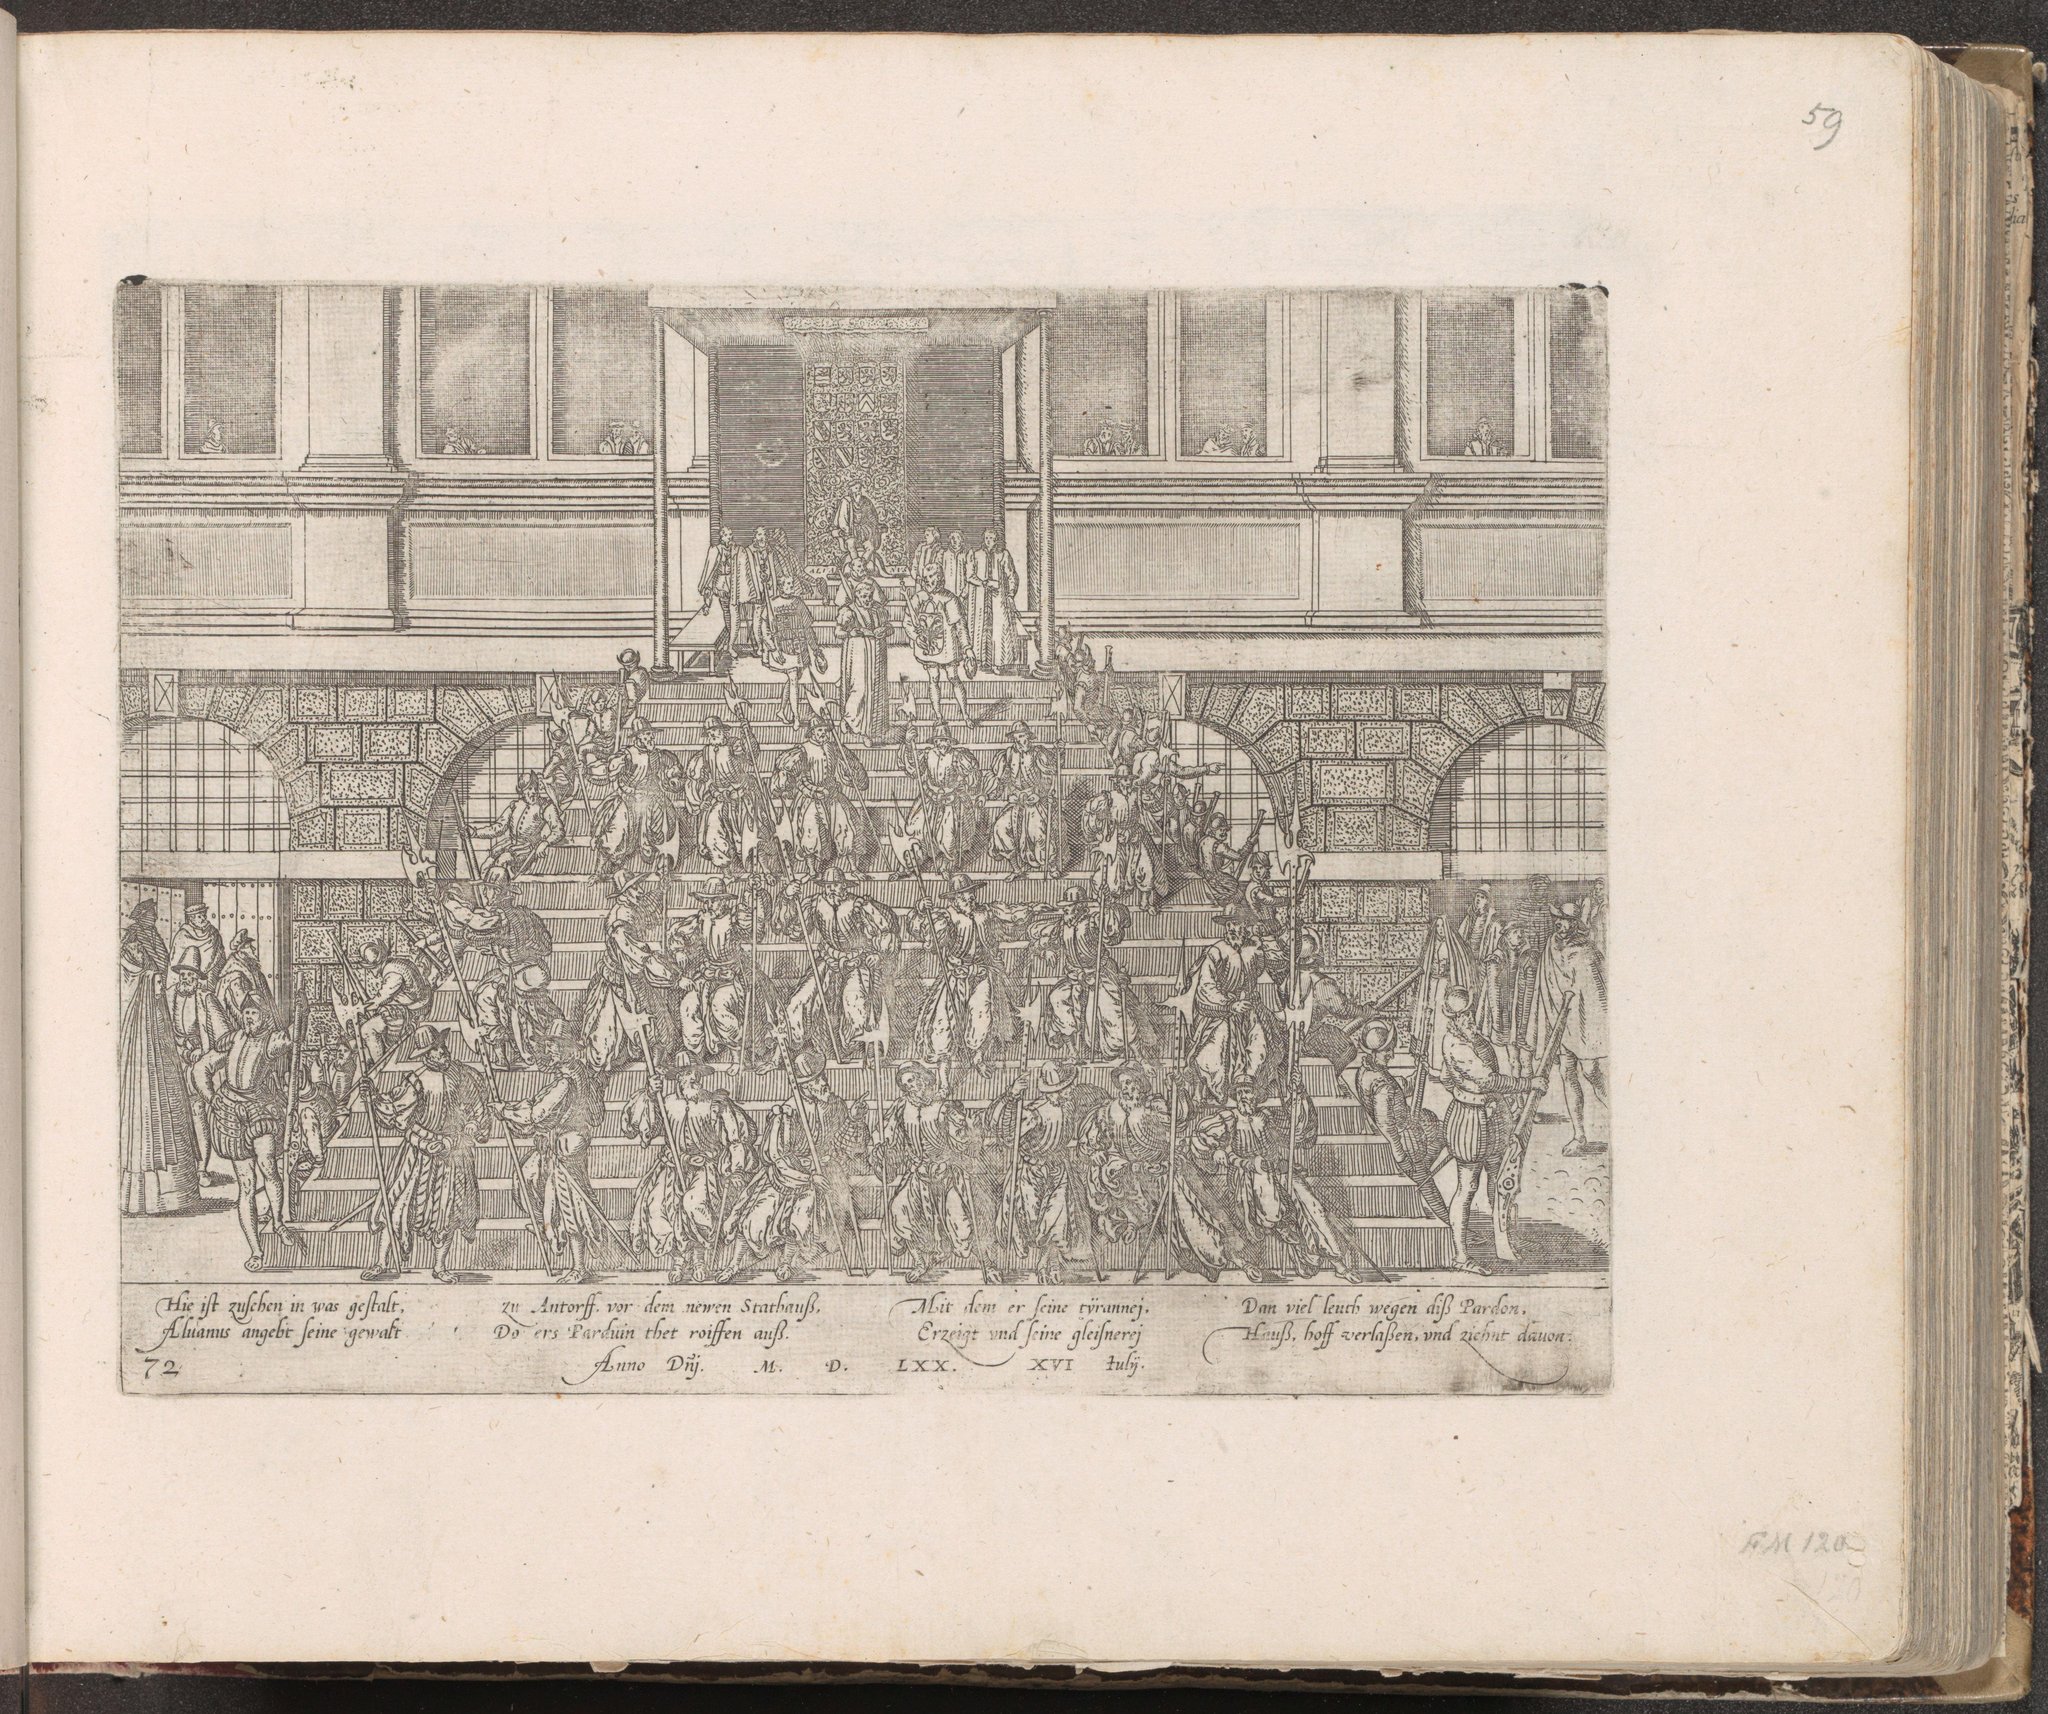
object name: history print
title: Afkondiging van het Generaal Pardon, 1570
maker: frans hogenberg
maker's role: print maker, publisher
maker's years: 1538-1590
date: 1570-1572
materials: paper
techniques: etching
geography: cologne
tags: fernando álvarez de toledo (3rd duke of alba), granting mercy; free pardon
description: Afkondiging van het Generaal Pardon, 16 juli 1570. Op een stellage voor het stadhuis van Antwerpen laat Alva het Algemeen Pardon voorlezen. Bovenaan zit Alva op een troon, op de trappen daaronder zitten soldaten. Met onderschrift van 8 regels in het Duits.Linksonder genummerd: 72. De prent maakt deel uit van een album.